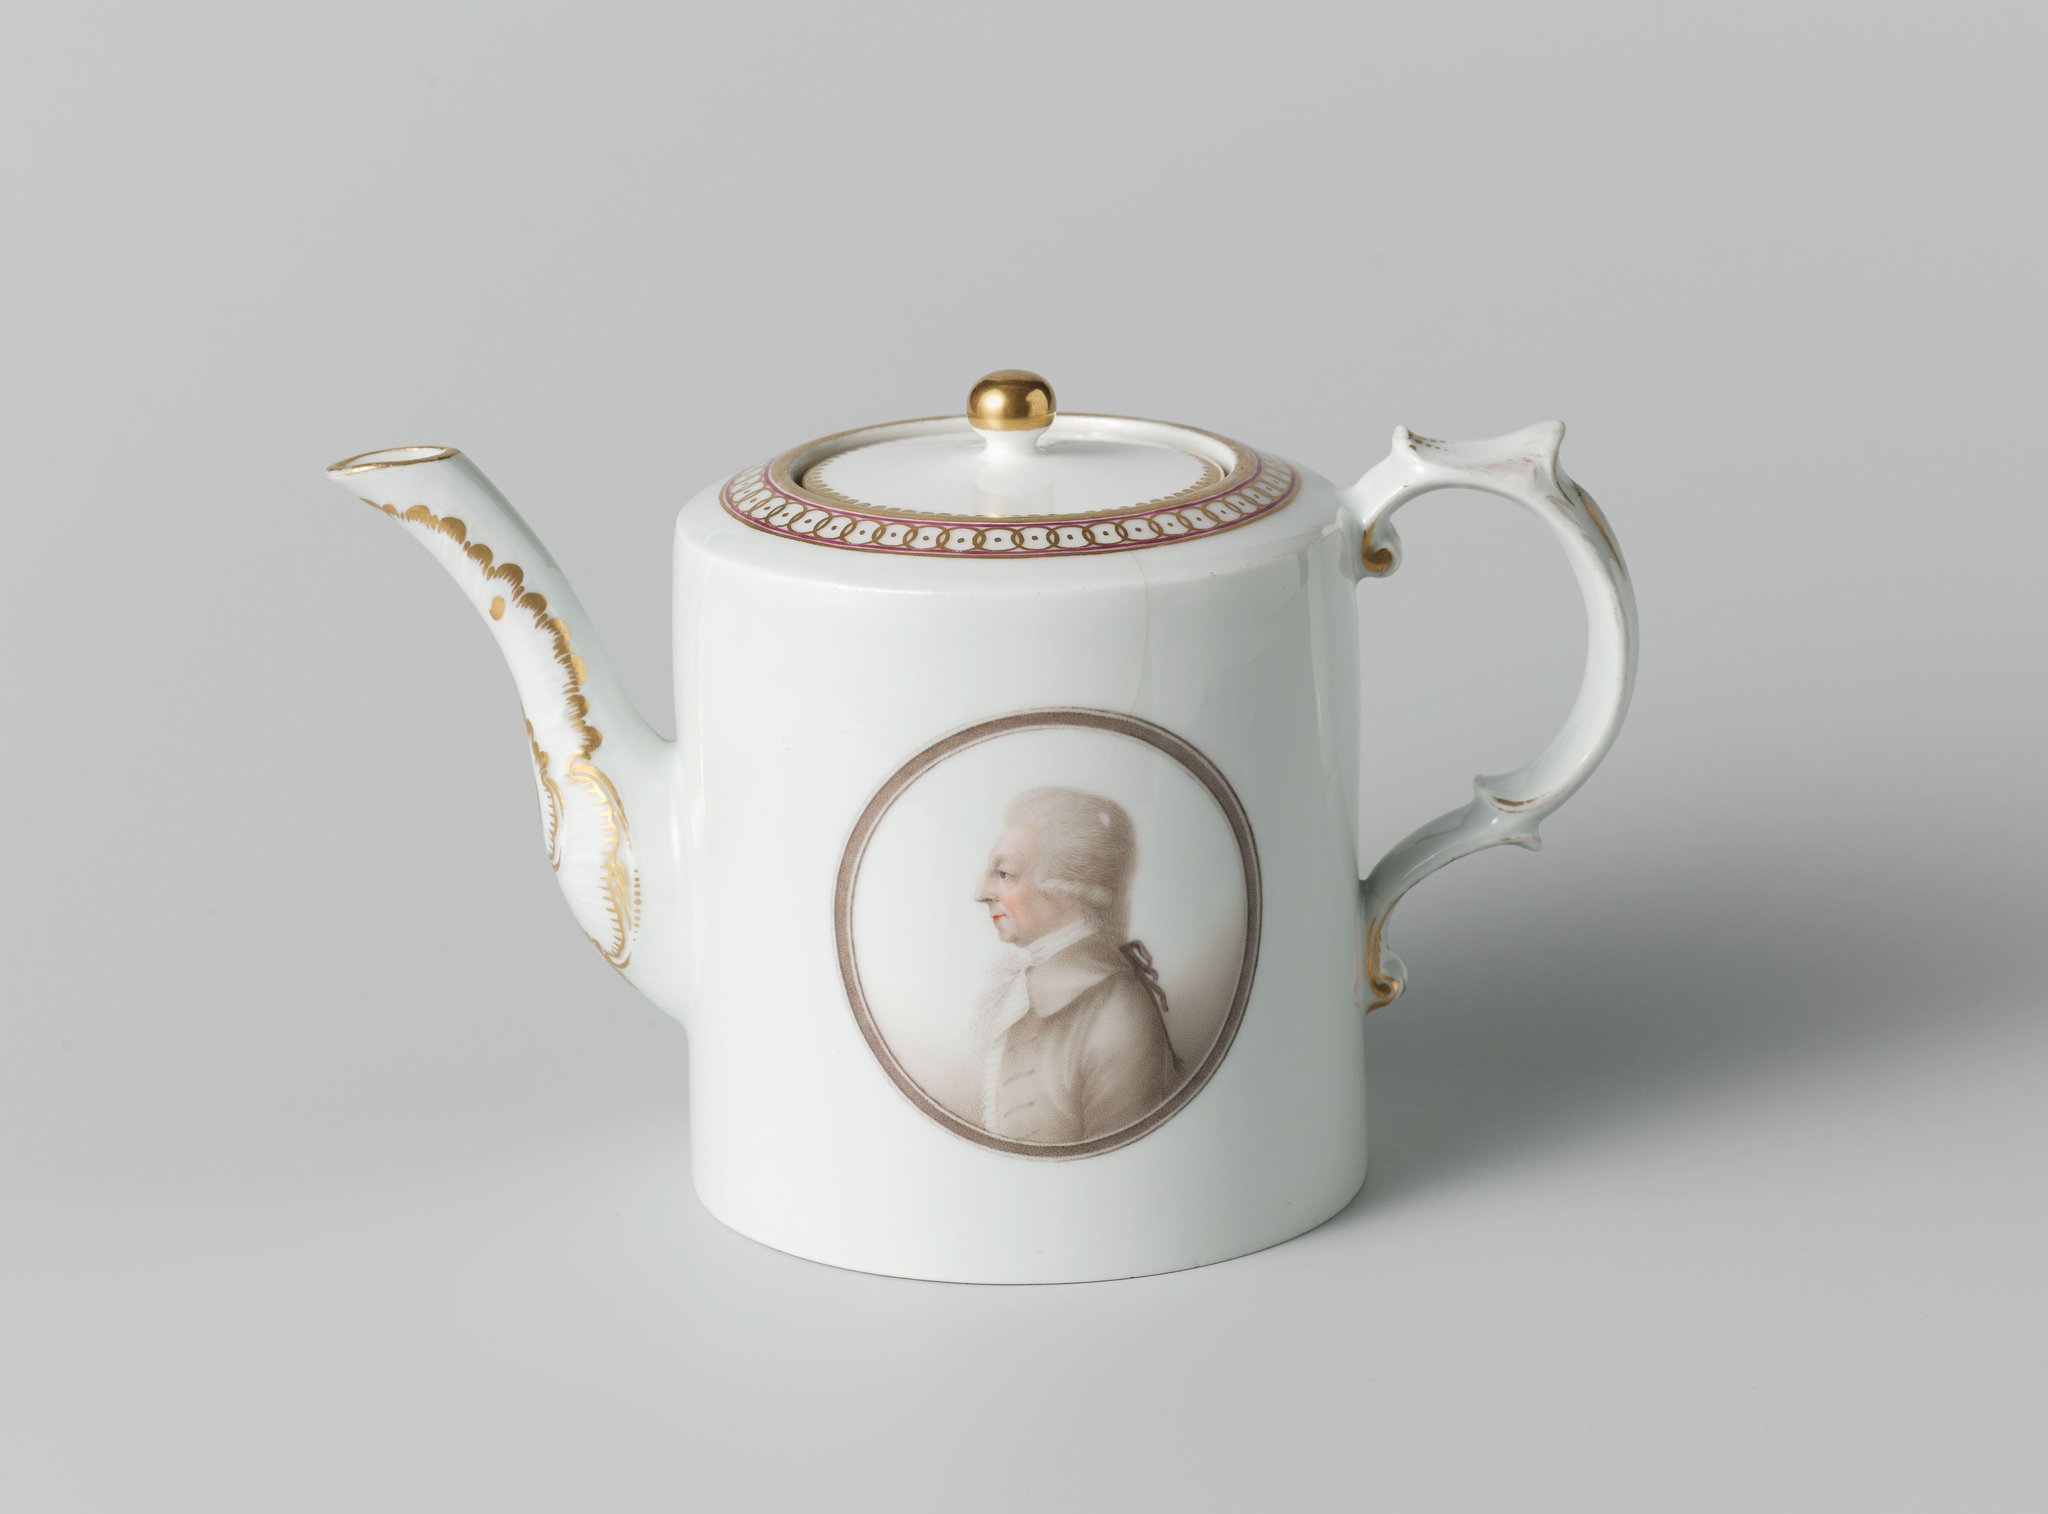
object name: lid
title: Cover of a teapot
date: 1775-1785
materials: glaze, gold, paint, porcelain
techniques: firing, forming, gilding, turning, vitrification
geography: furstenberg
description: Deksel van een theepot, beschilderd op het glazuur in goud. Versierd met een band van halve gouden bollen; ronde dekselknop. Deksel hoort origineel niet bij de theepot.